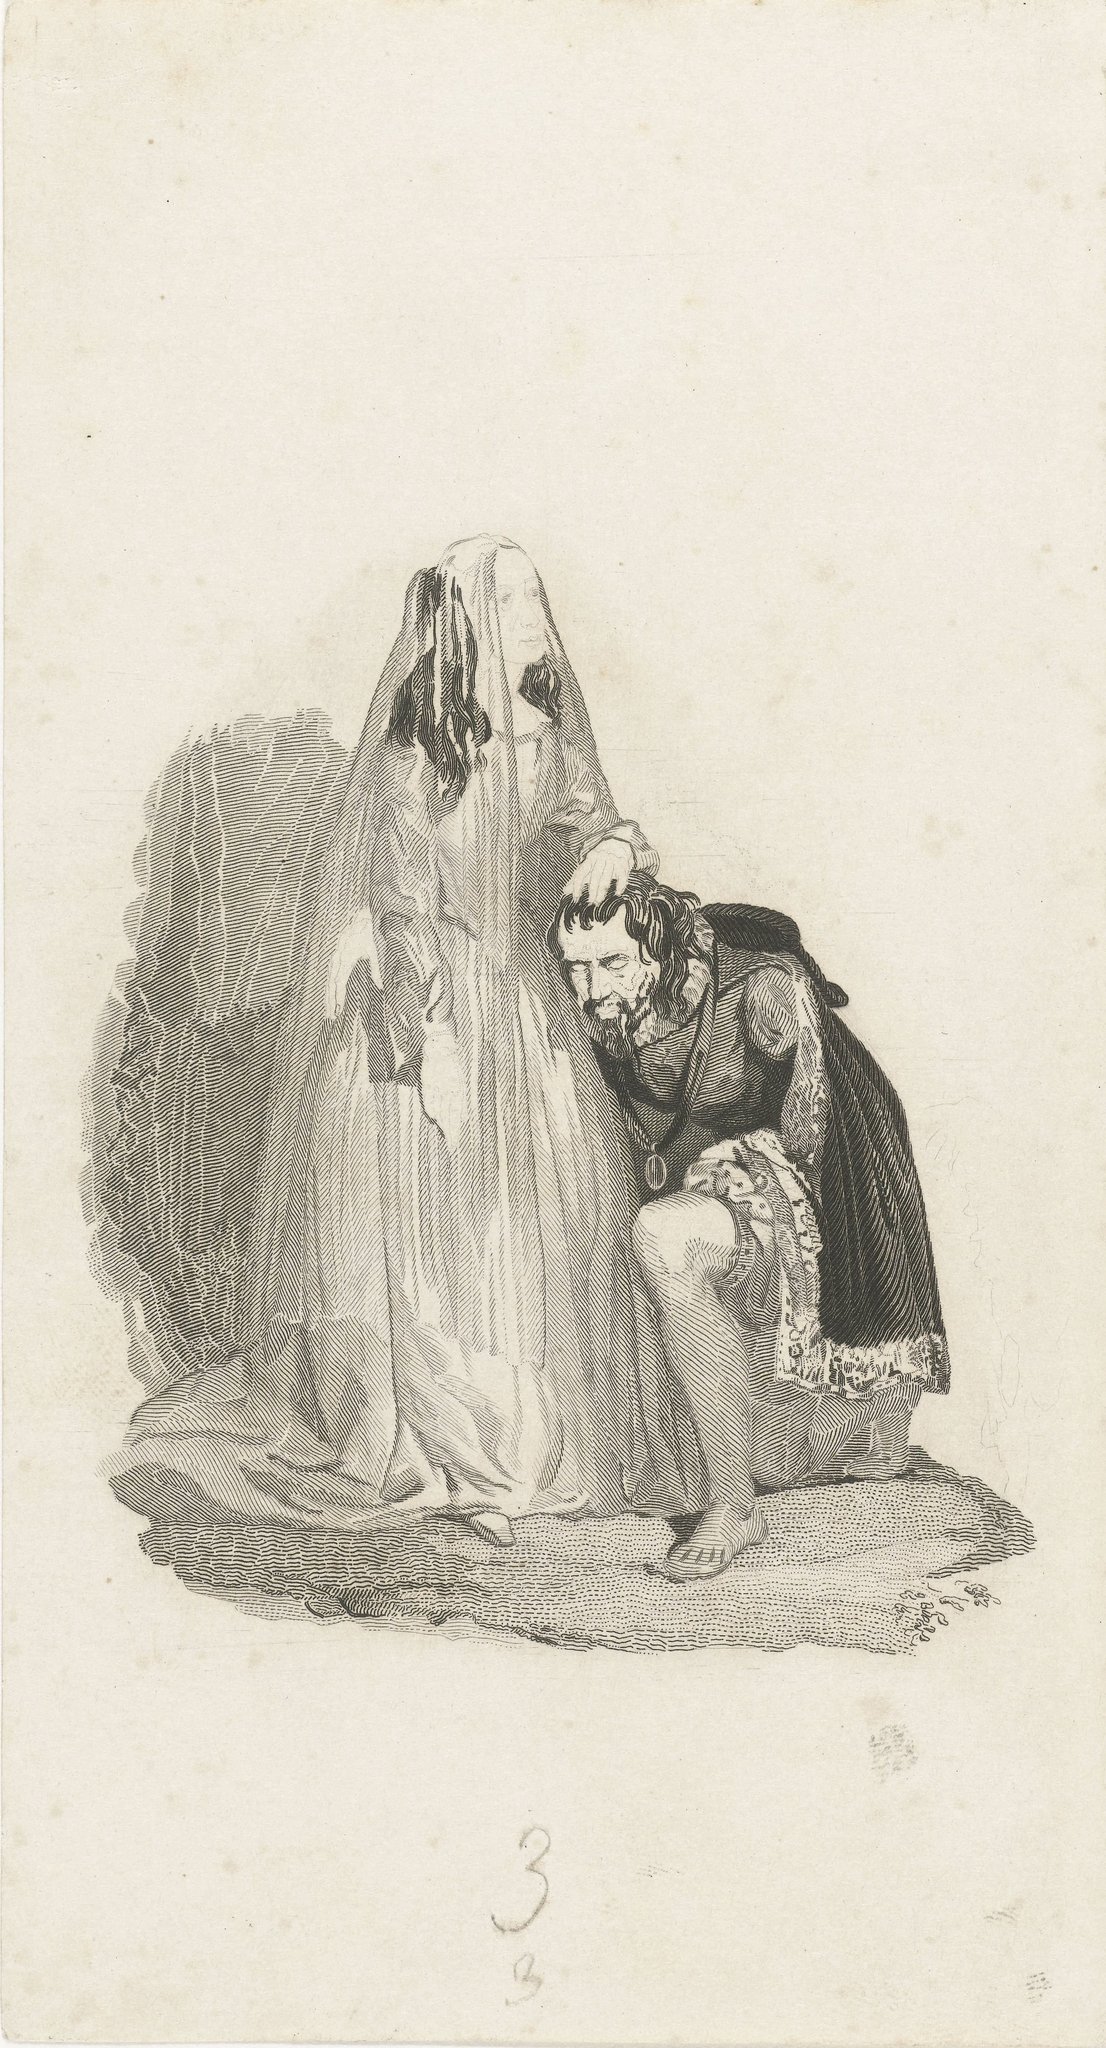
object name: print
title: Jose knielt neer voor Florinde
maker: henricus wilhelmus couwenberg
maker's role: draughtsman, print maker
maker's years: 1814-1845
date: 1838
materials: paper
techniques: engraving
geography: amsterdam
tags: hidden love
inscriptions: collector's mark: Lugt 2228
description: Titelpagina voor: Nicolaas Beets, Jose. Een verhaal. Amsterdam: J. Immerzeel jr., 1838.